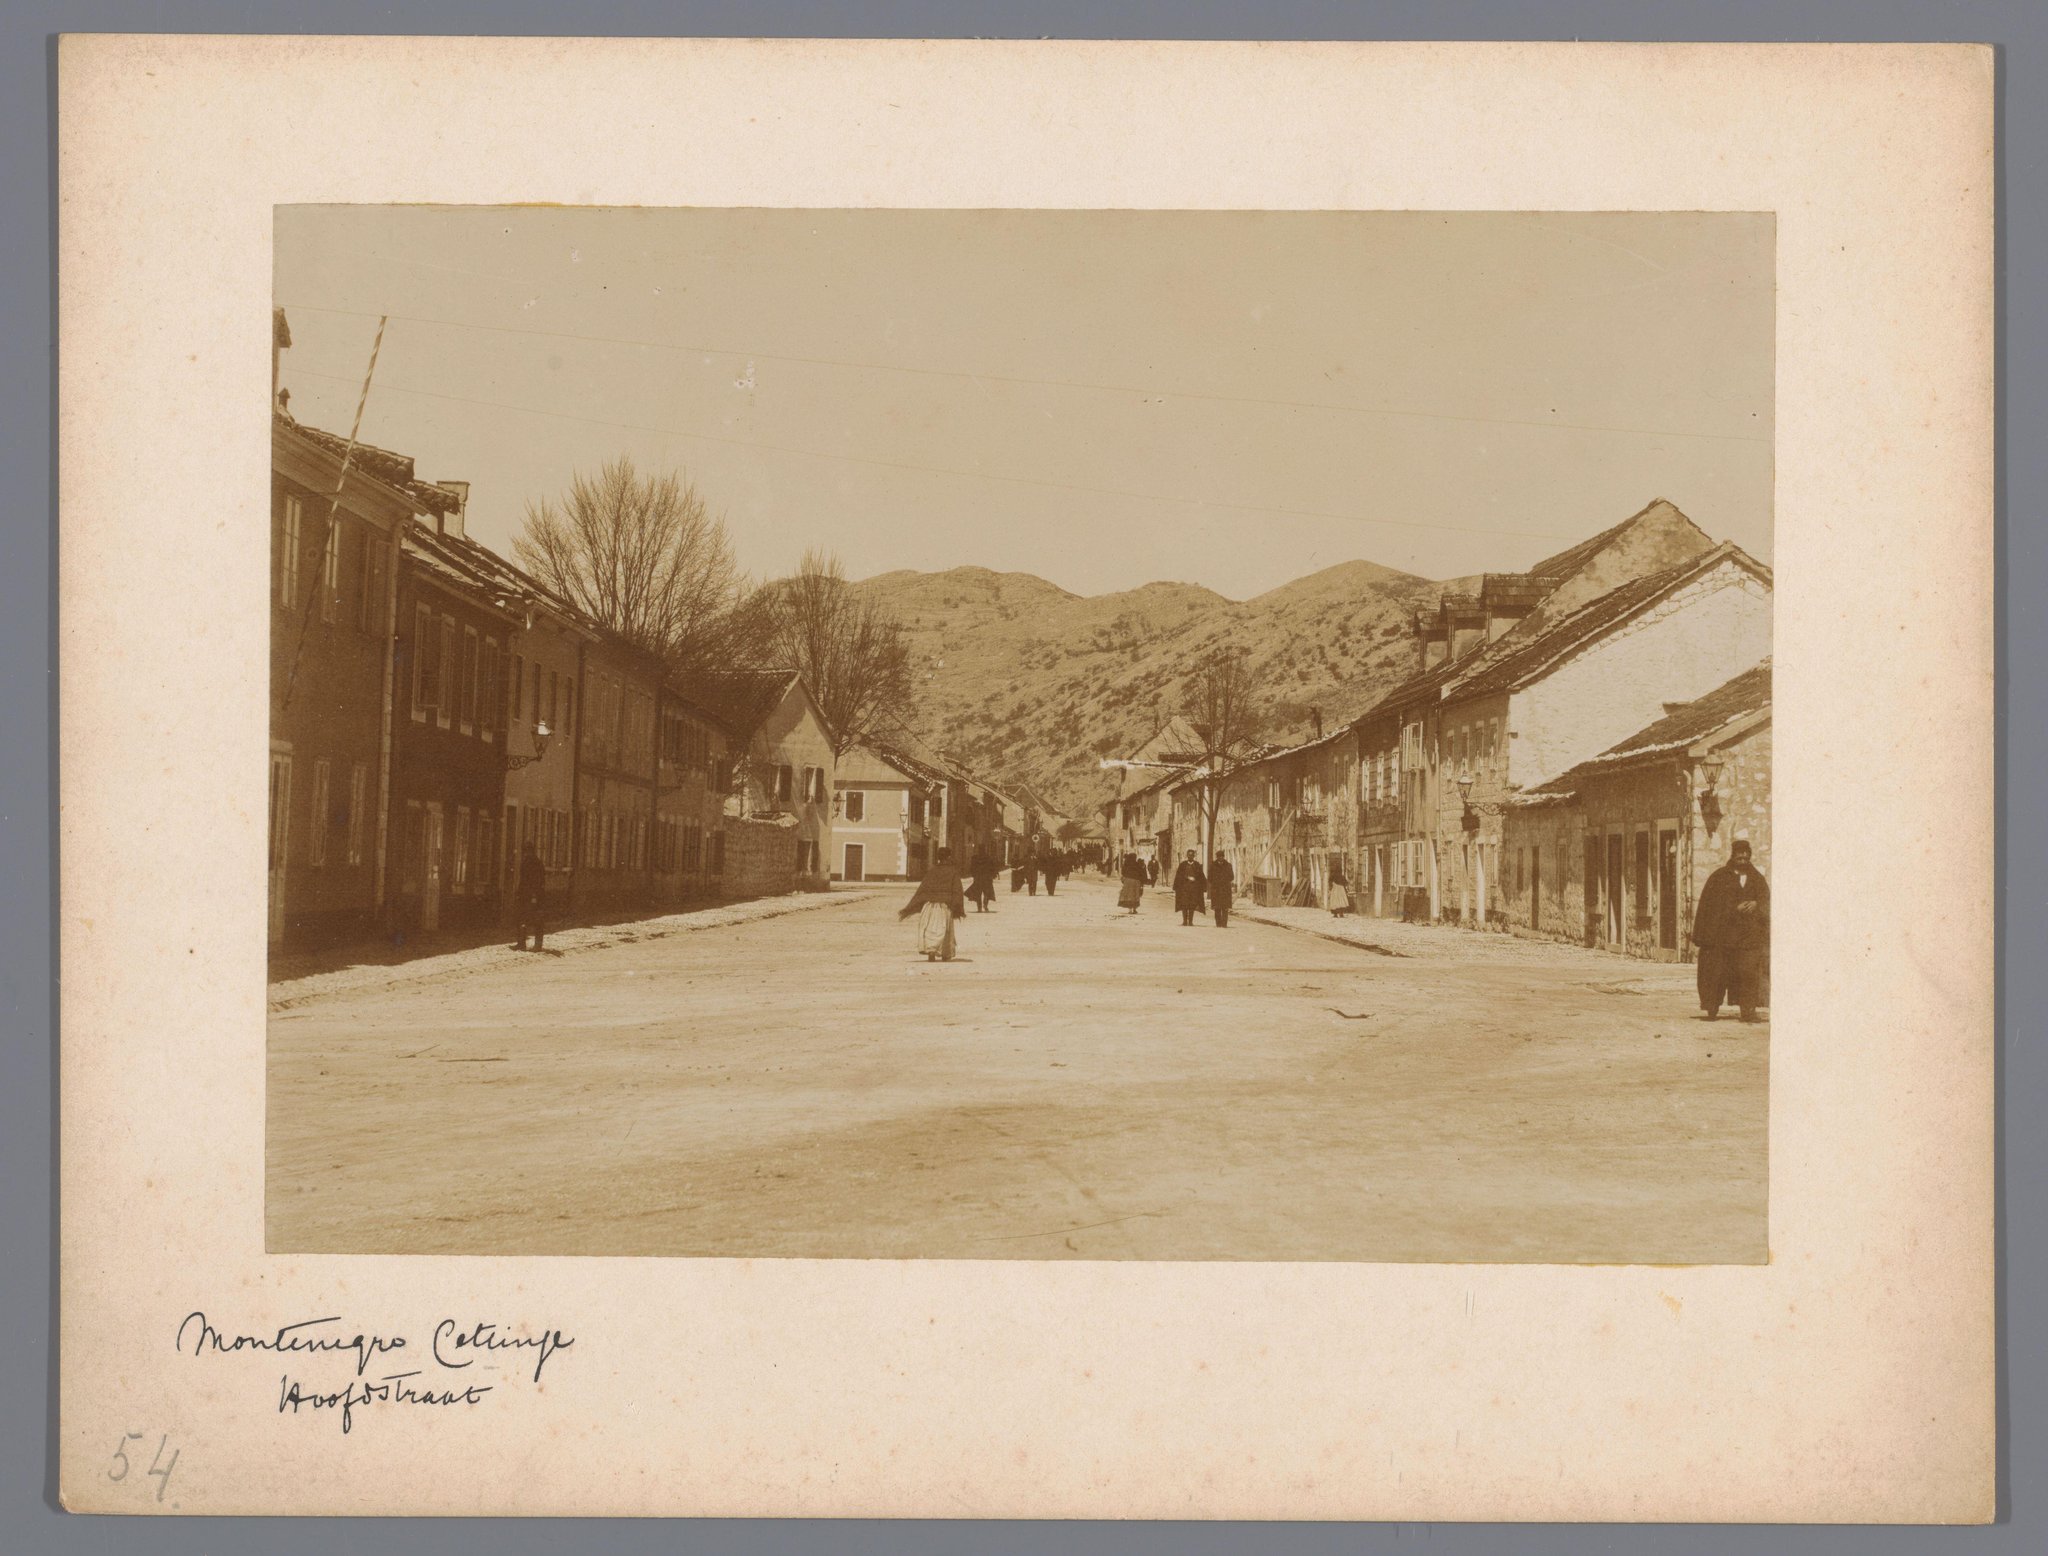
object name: photograph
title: Montenegro, Cetinje, Hoofdstraat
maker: Anonymous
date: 1880-1910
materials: paper, cardboard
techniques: collodion silver print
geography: cetinje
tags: street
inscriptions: number: ‘54’